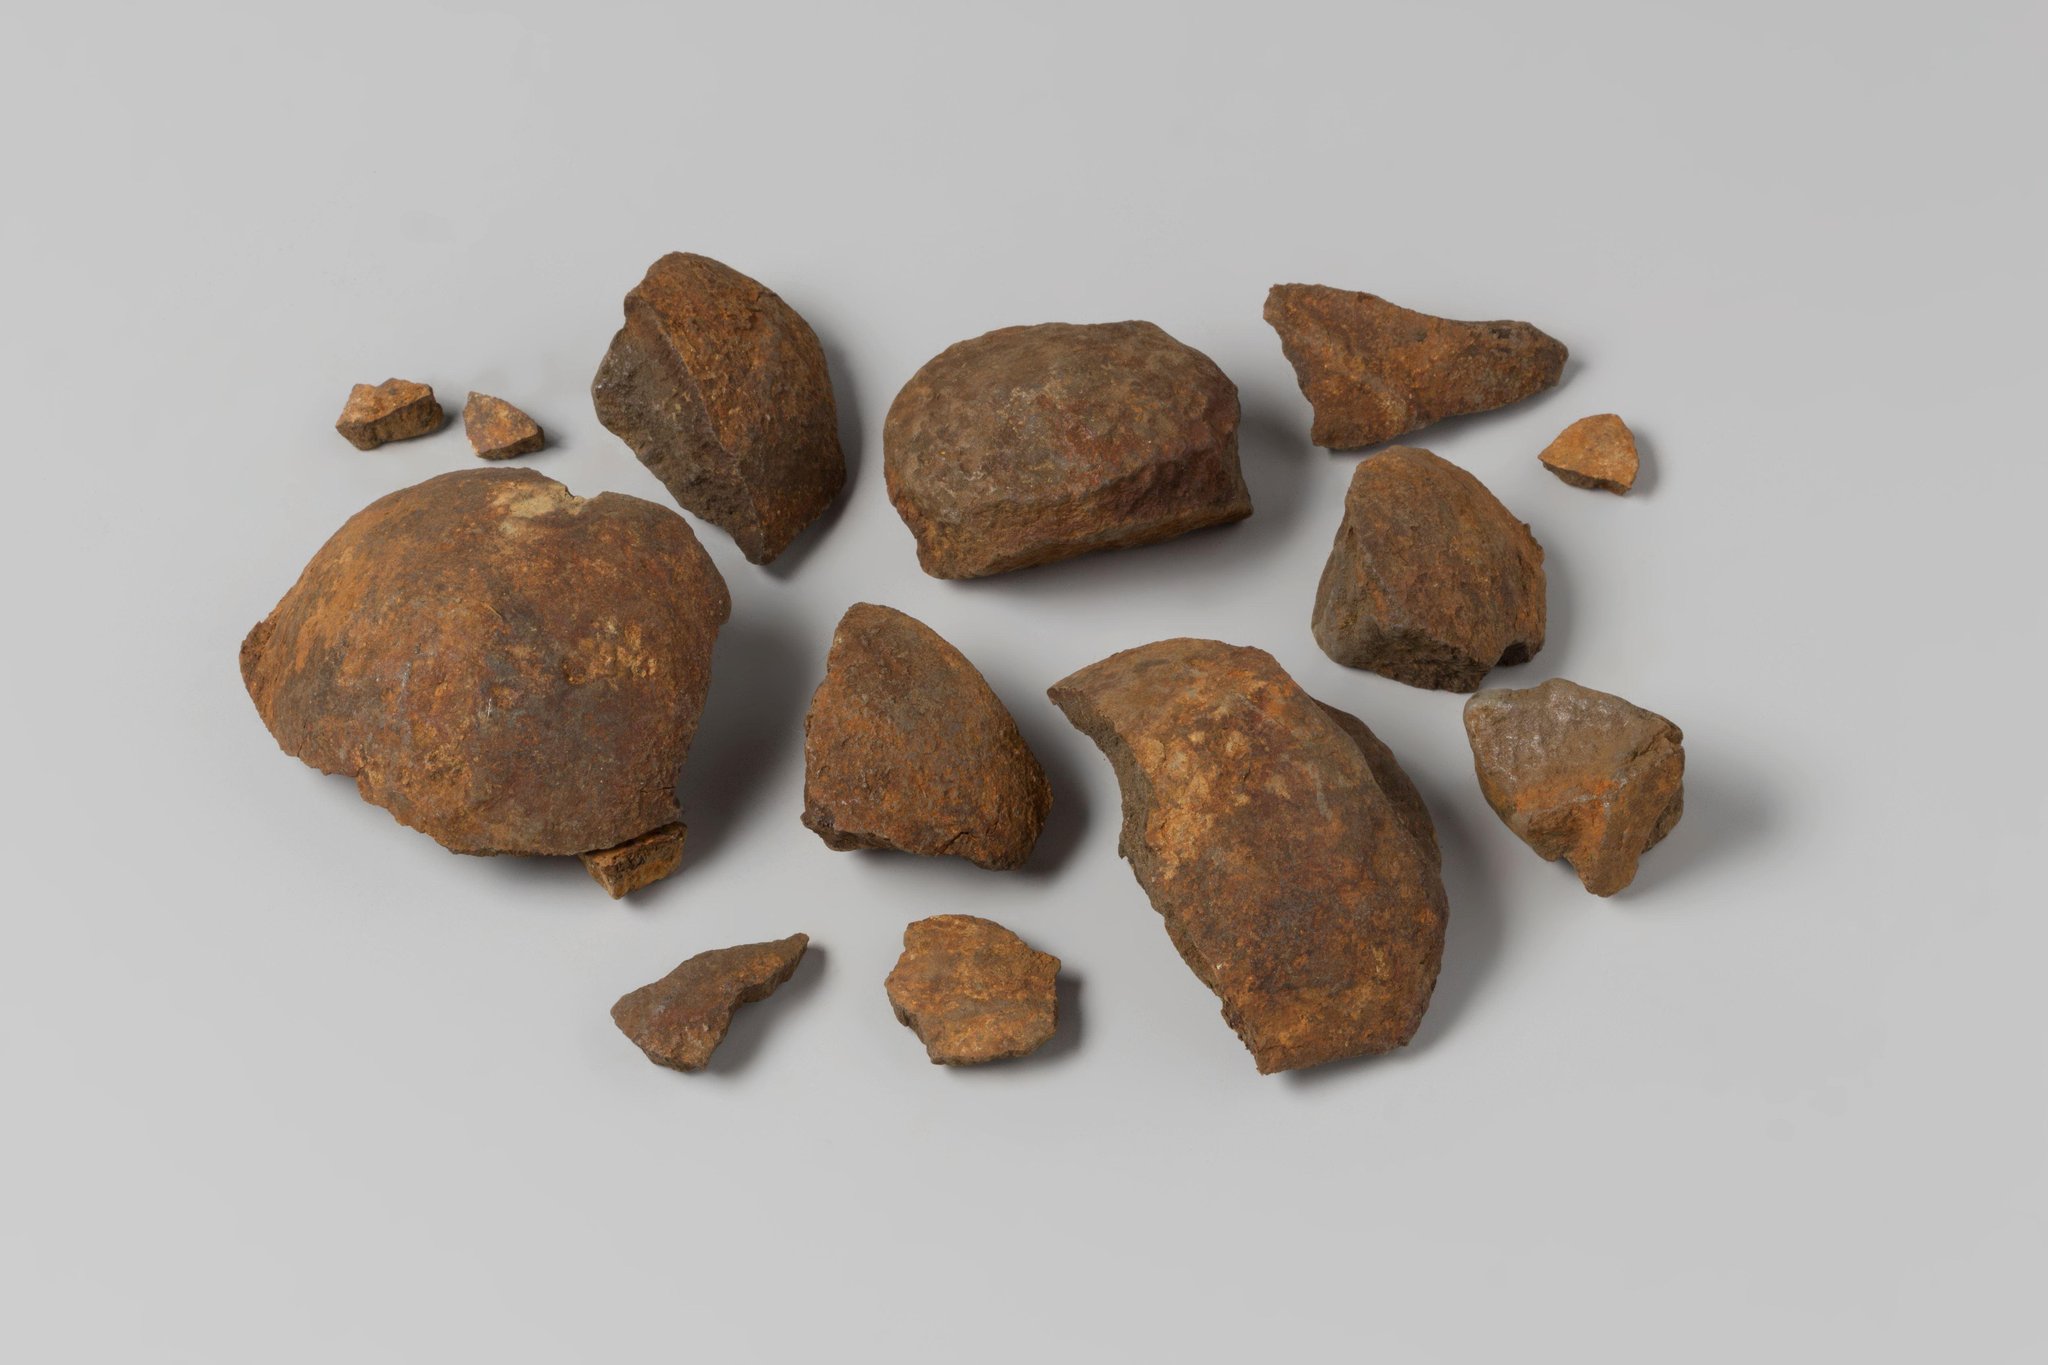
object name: bar shot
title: In stukken uit elkaar gevallen kogel uit het wrak van de Oost-Indiëvaarder Hollandia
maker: Anonymous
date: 1700-1743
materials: iron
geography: netherlands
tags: verenigde oostindische compagnie, hollandia (schip), annet